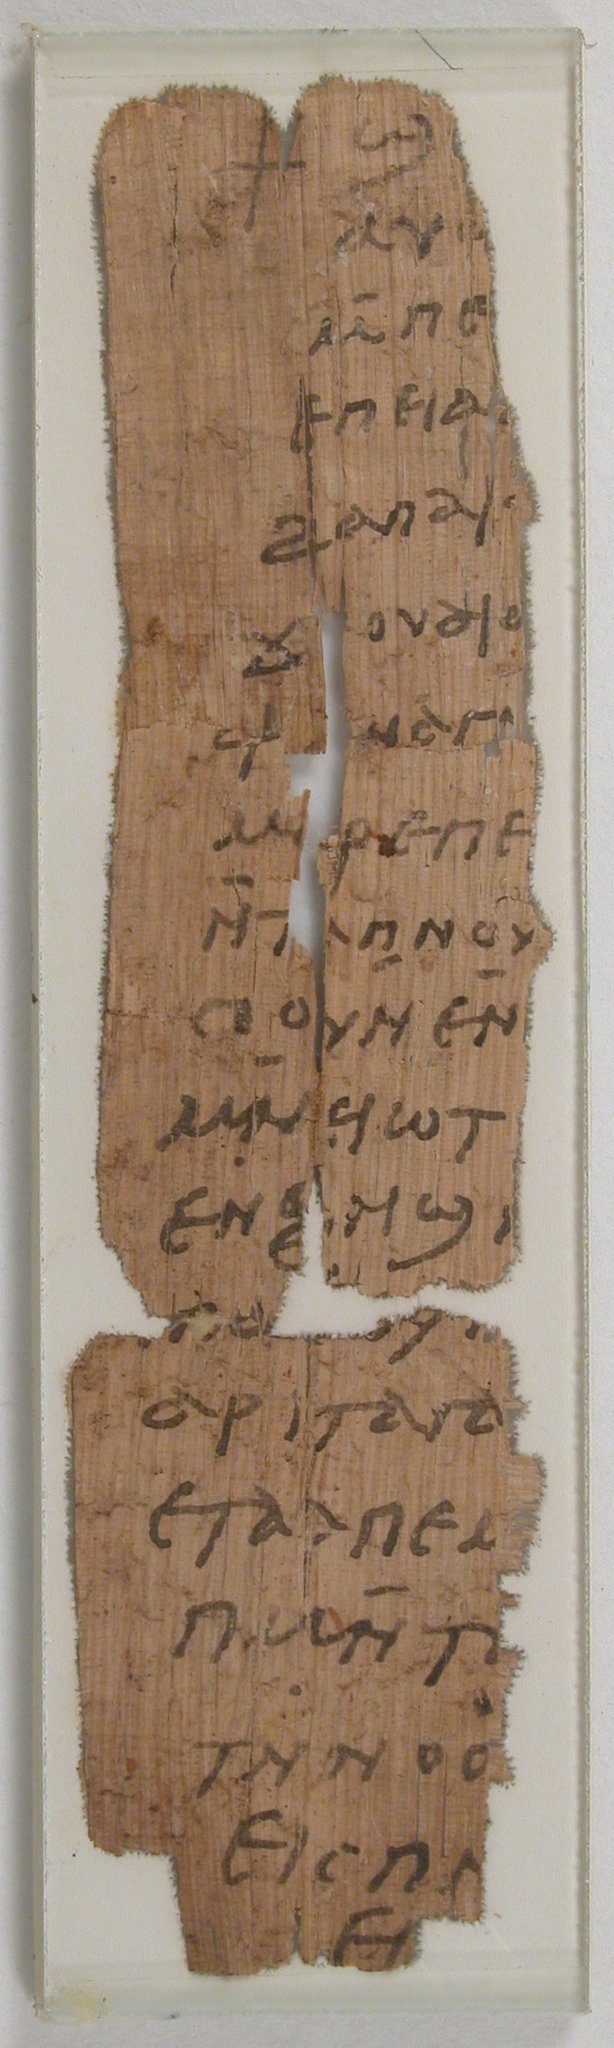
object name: fragment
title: Papyrus Fragments of a Letter from Daniel and Jacob to Pesenthius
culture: coptic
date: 601-700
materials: ink, papyrus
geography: egypt